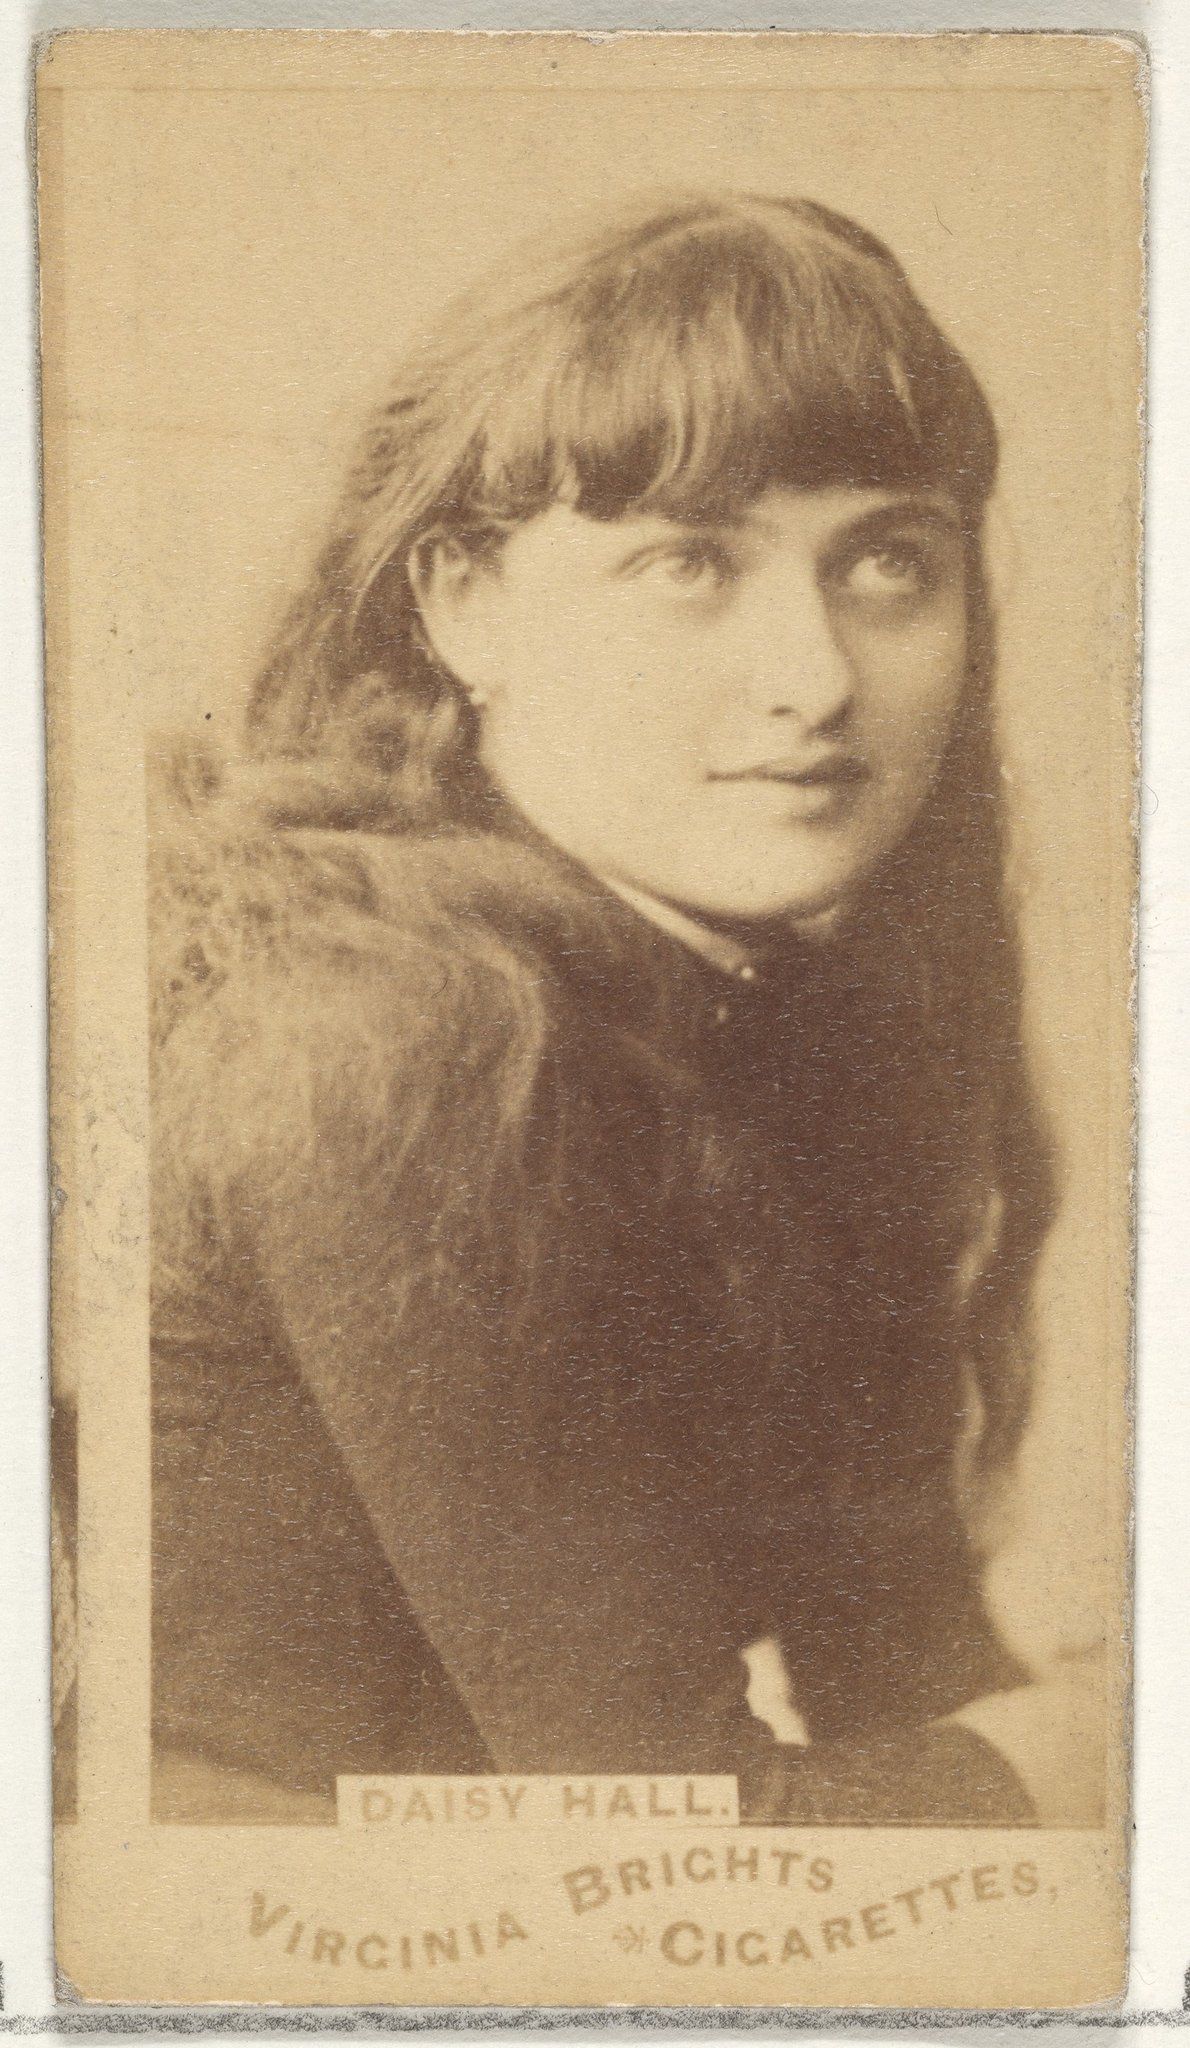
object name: photograph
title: Daisy Hall, from the Actors and Actresses series (N45, Type 1) for Virginia Brights Cigarettes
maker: allen & ginter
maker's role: publisher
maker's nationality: american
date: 1888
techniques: albumen silver print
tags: portraits,women,actresses